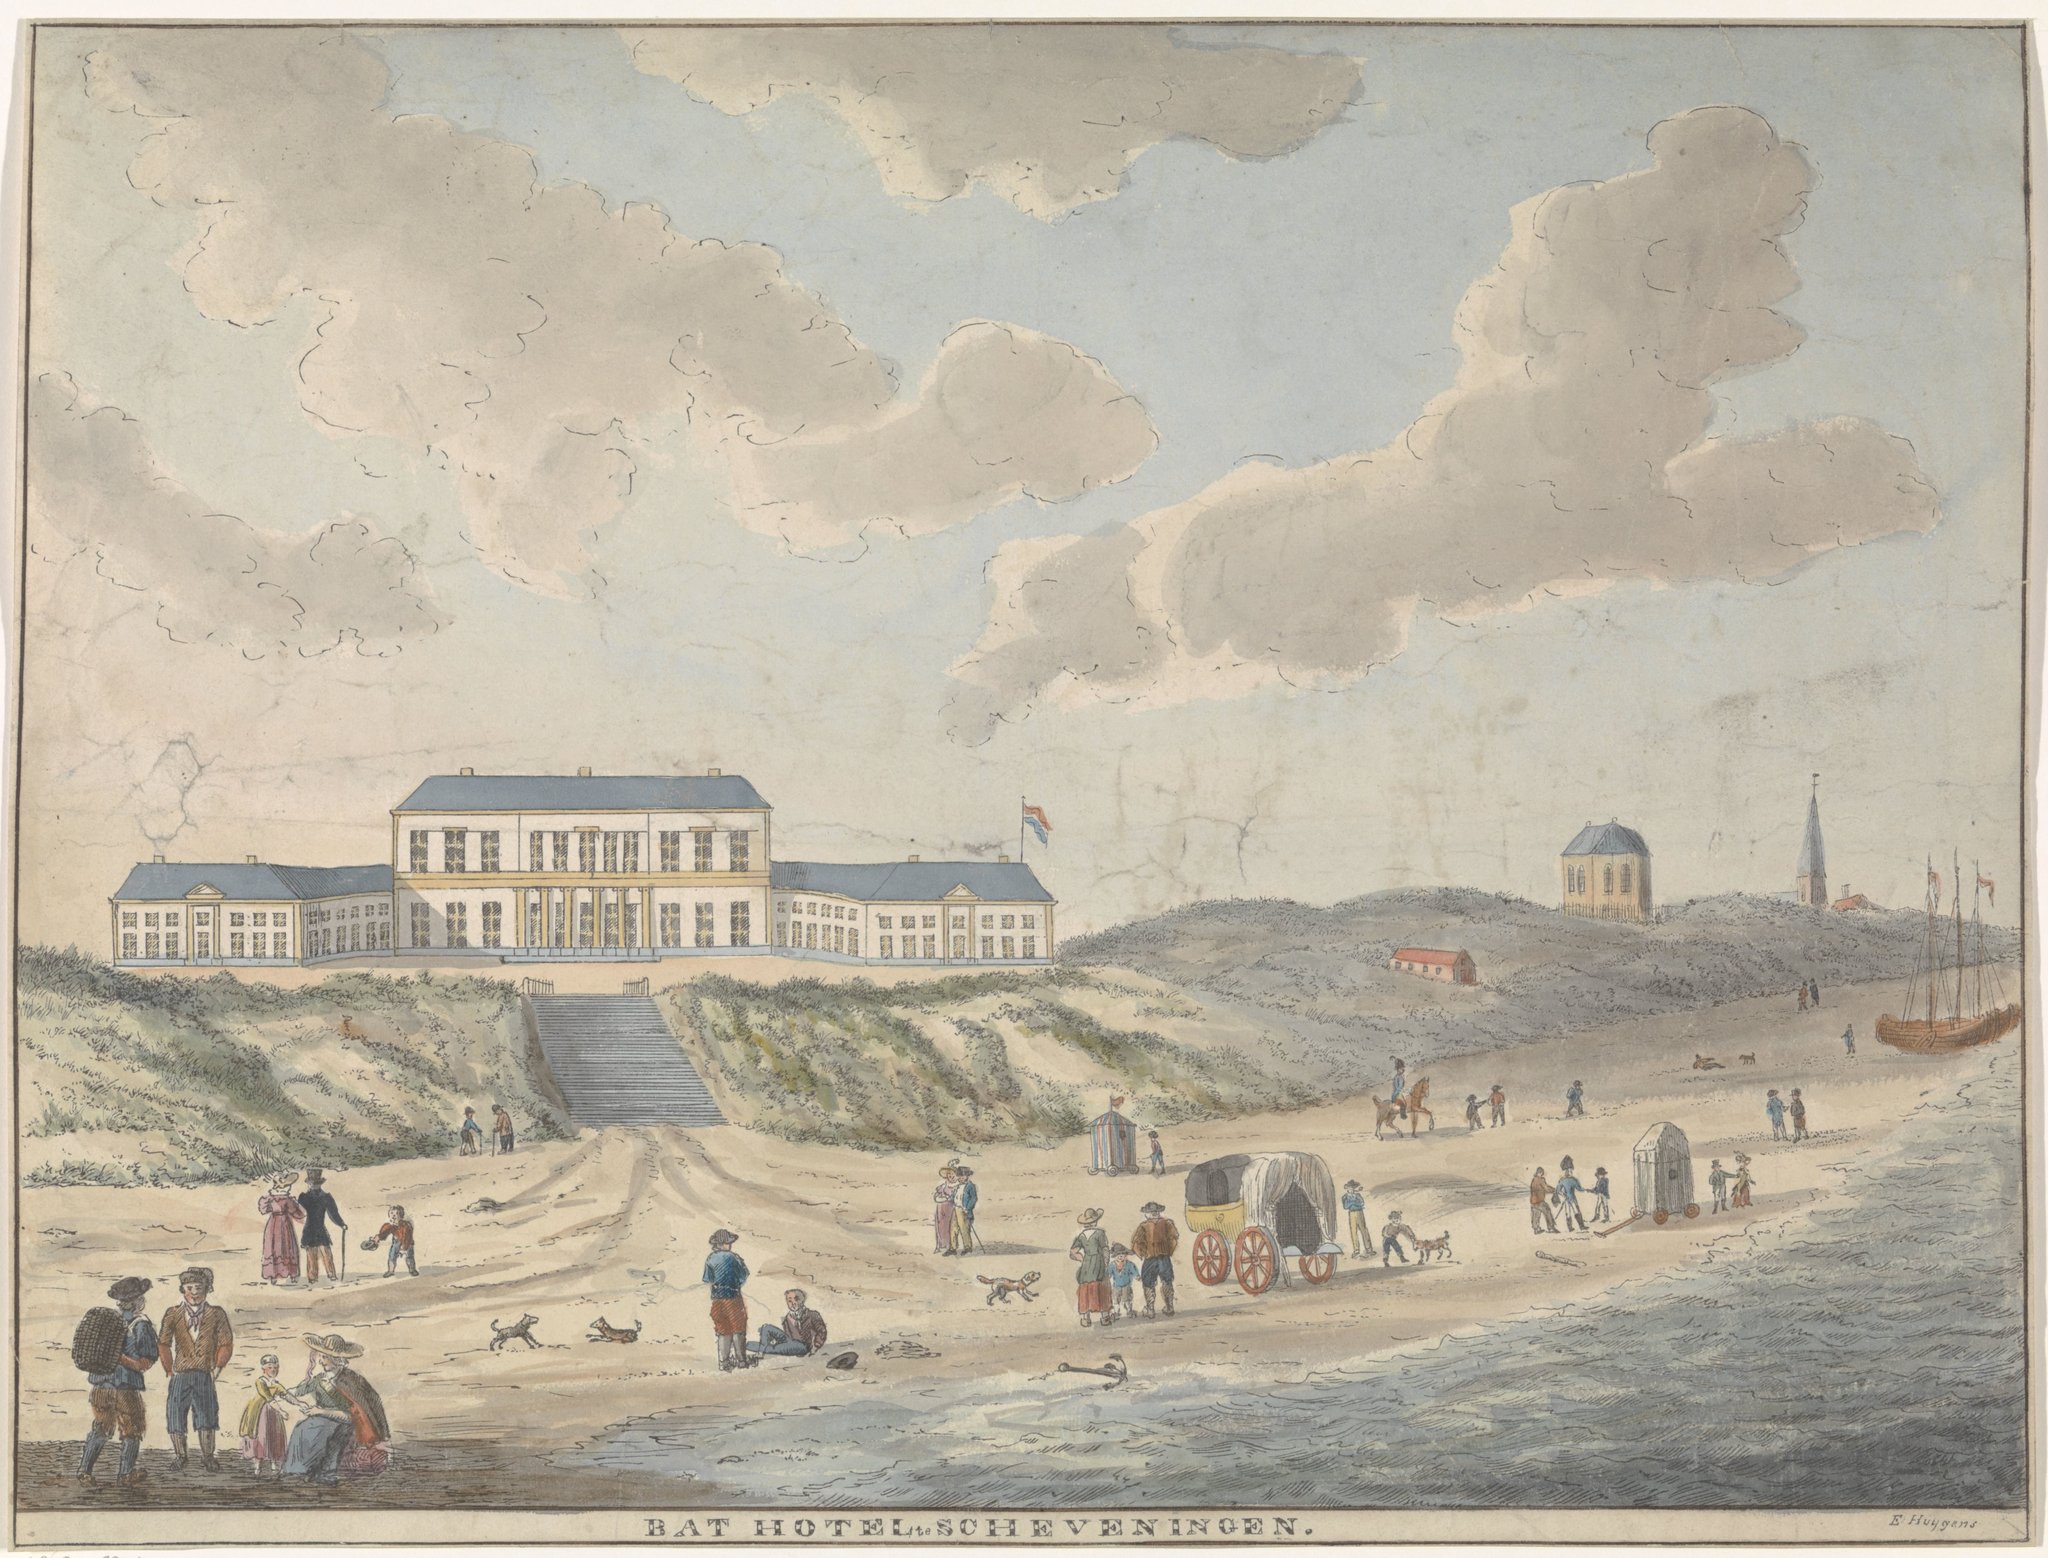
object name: print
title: Bat Hotel te Scheveningen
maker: e. huygens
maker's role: print maker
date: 1810-1830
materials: paper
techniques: etching, hand coloring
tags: beach (as place of recreation), hotel, hostelry, inn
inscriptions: collector's mark: Lugt 2228, collector's mark: Lugt 2760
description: Gezicht op het badhotel van Scheveningen. Daarvoor het strand met wandelaars, honden en boten.